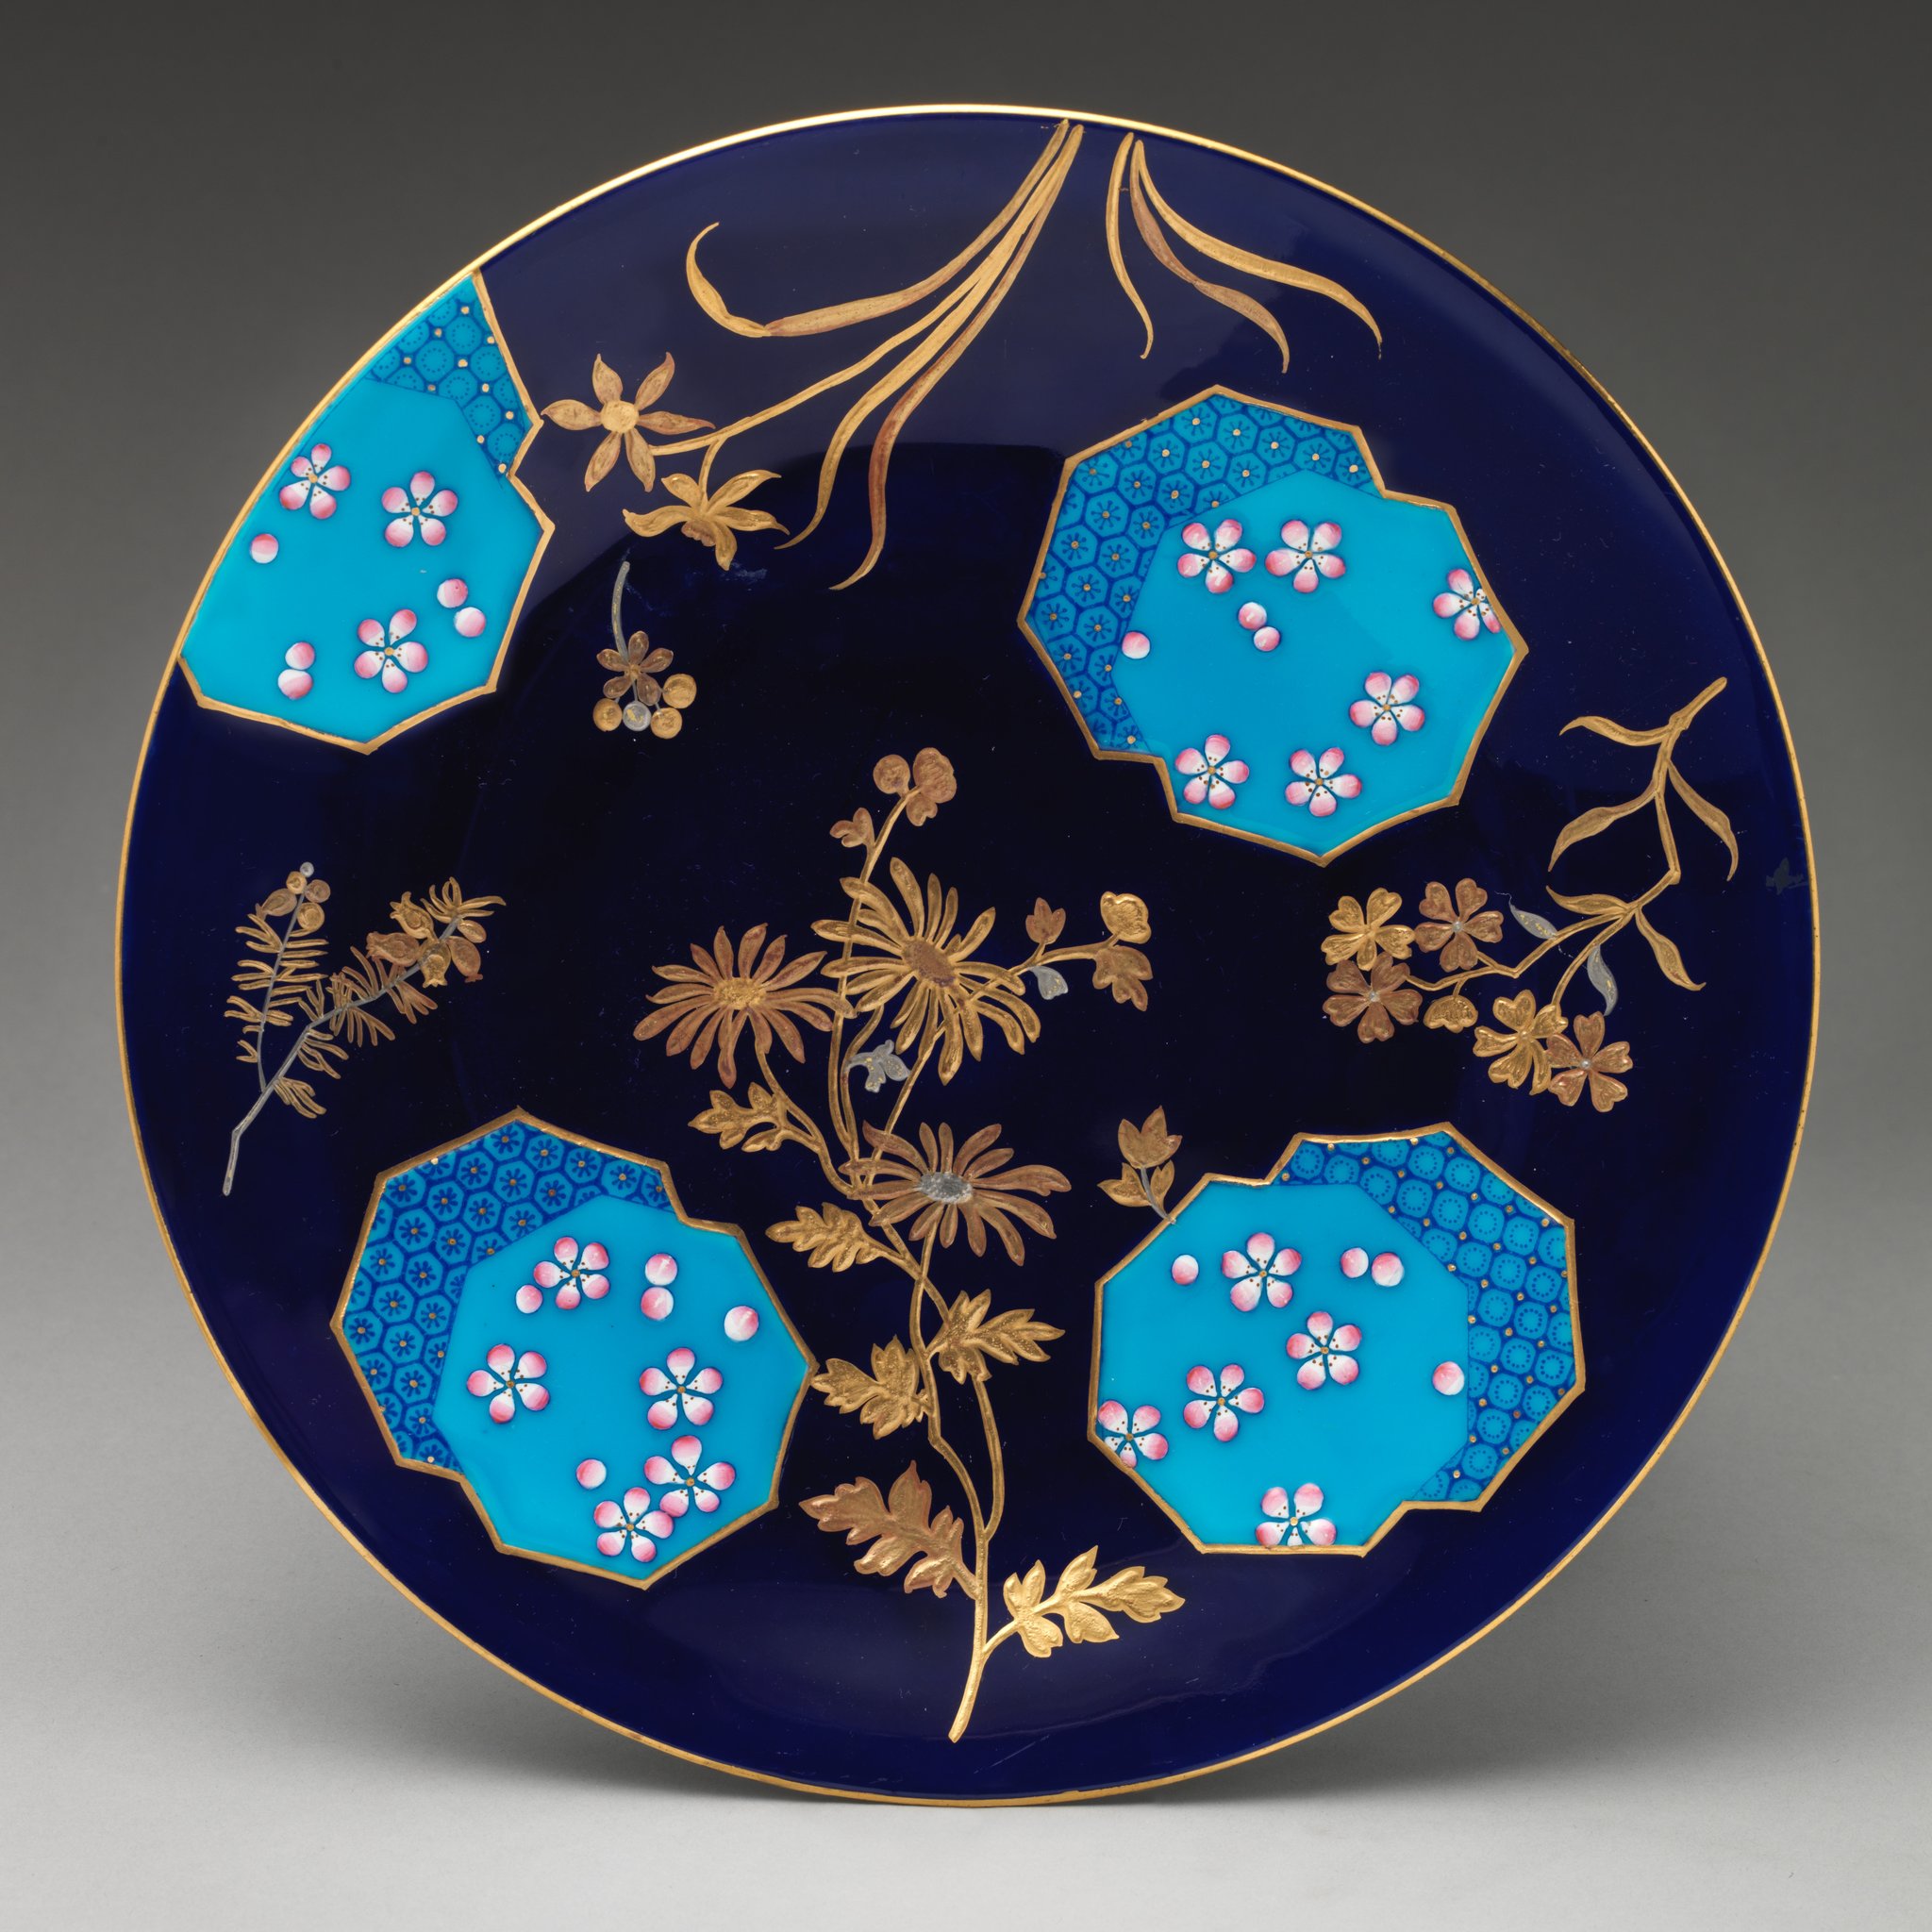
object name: plate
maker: minton(s)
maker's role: factory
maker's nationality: british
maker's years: 1793-2001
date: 1881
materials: bone china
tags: flowers